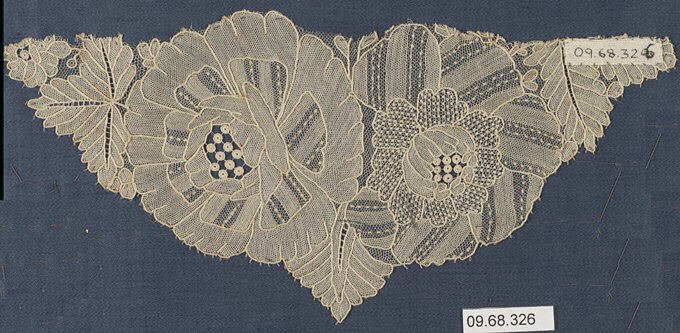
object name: specimen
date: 1801-1900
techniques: lace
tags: flowers